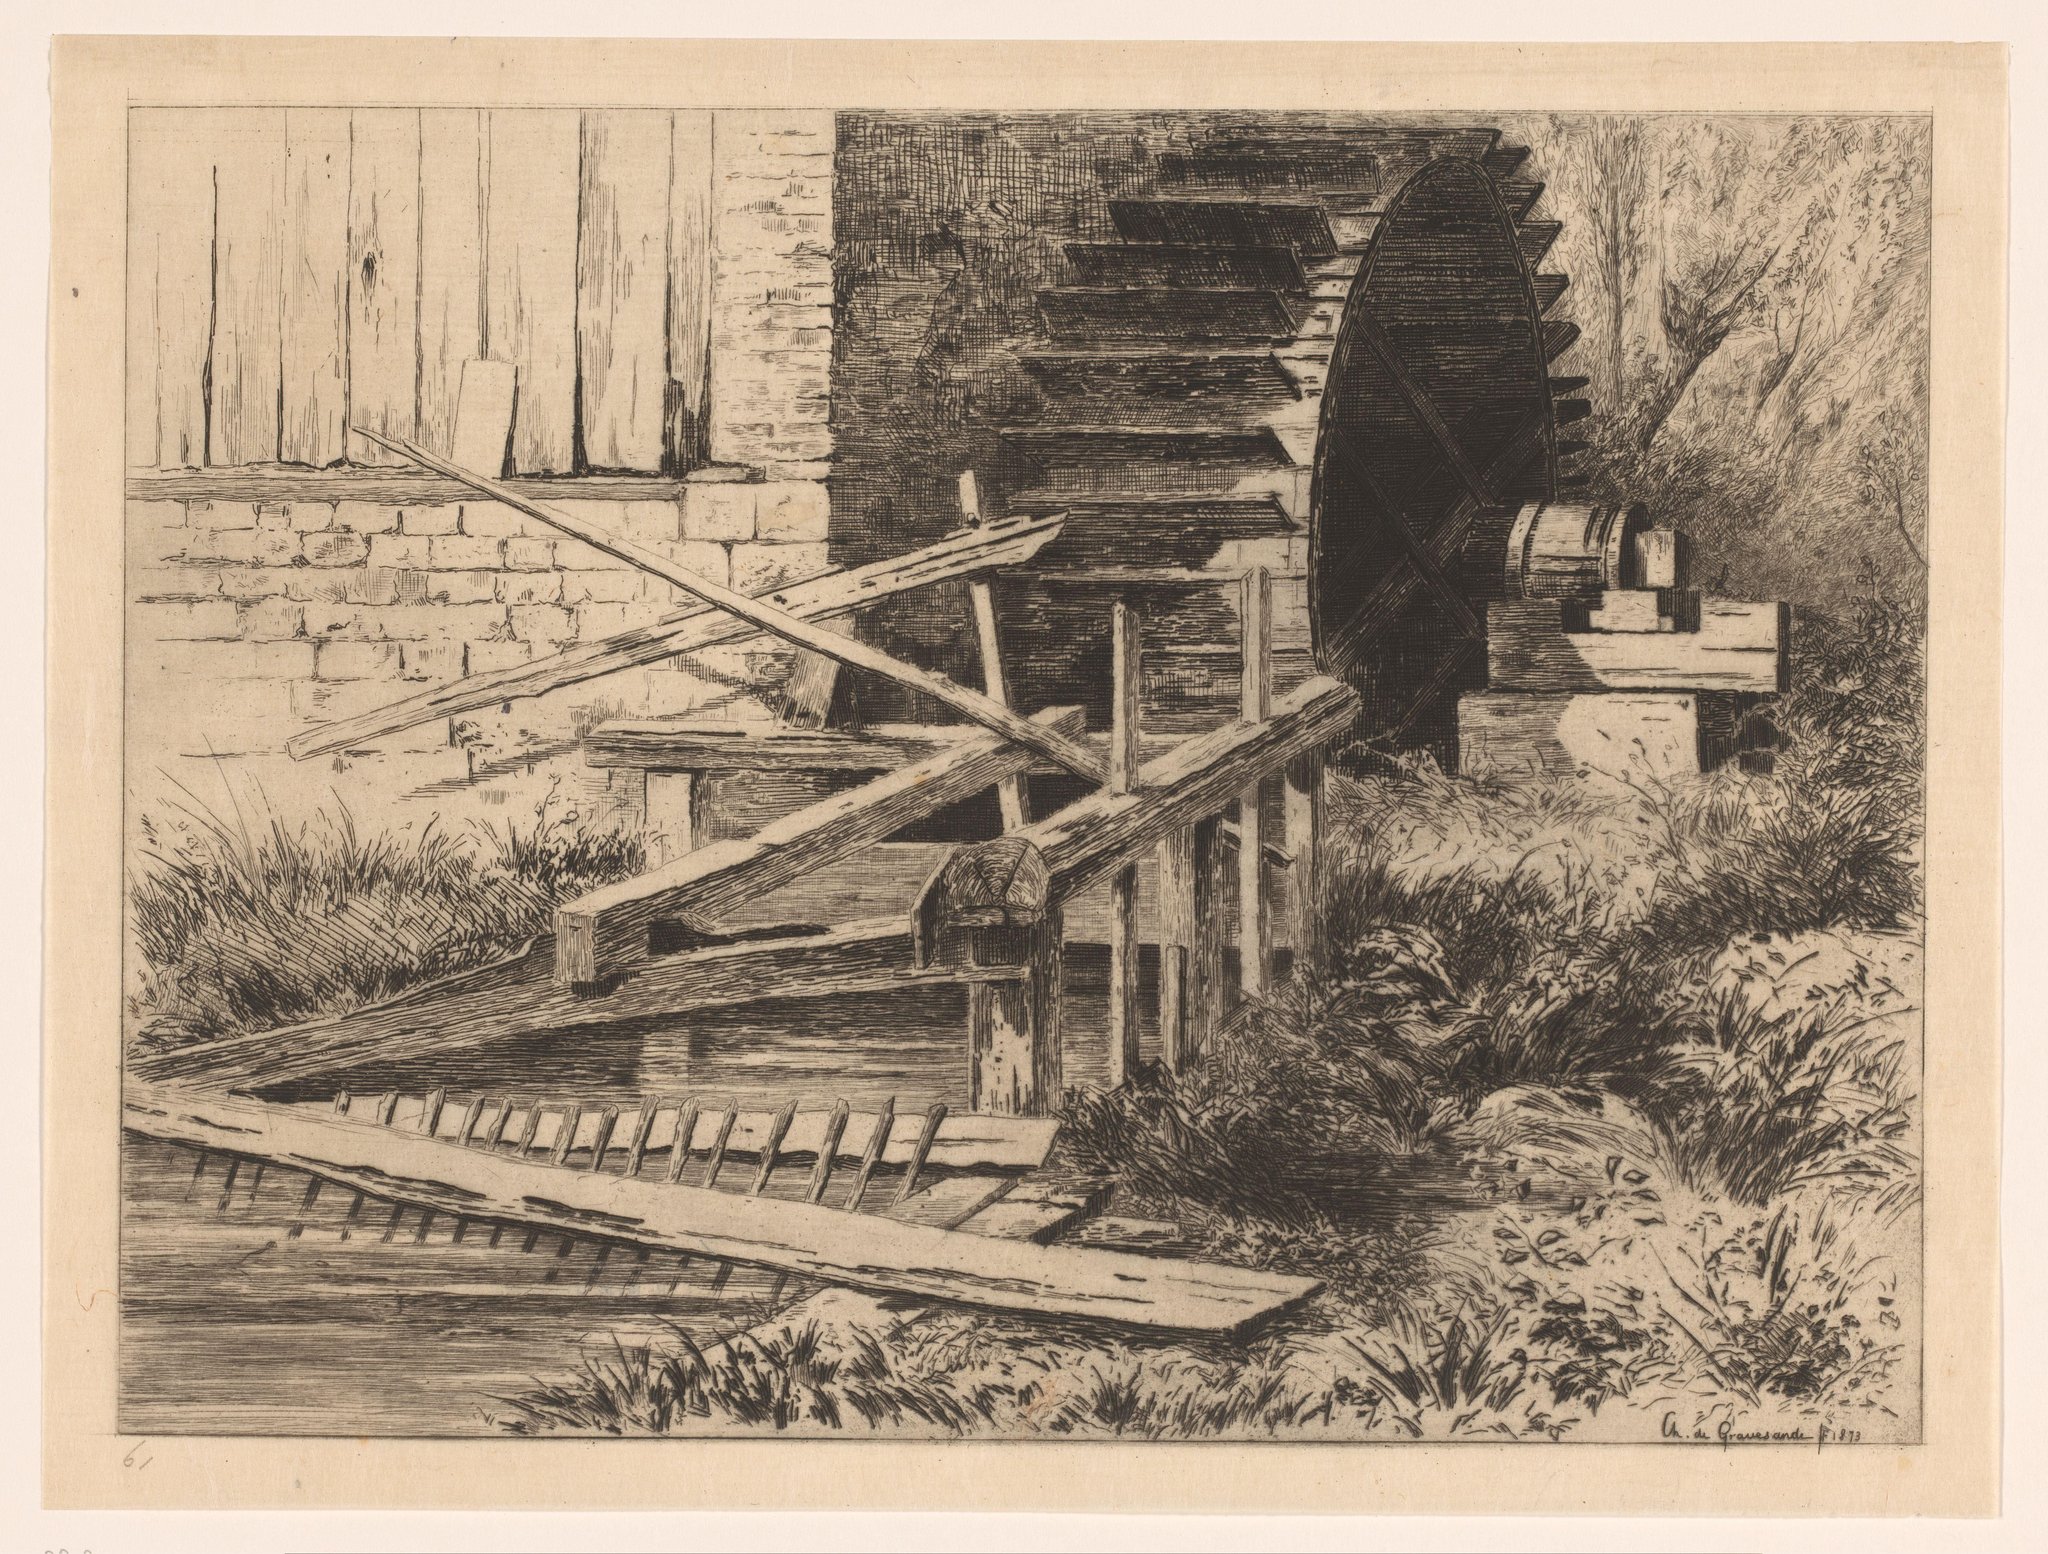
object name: print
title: Moulin dans les cressonnières à Veules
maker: carel nicolaas storm van s-gravesande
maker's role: draughtsman, print maker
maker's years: 1841-1924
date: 1873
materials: paper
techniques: etching, intaglio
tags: watermill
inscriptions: date